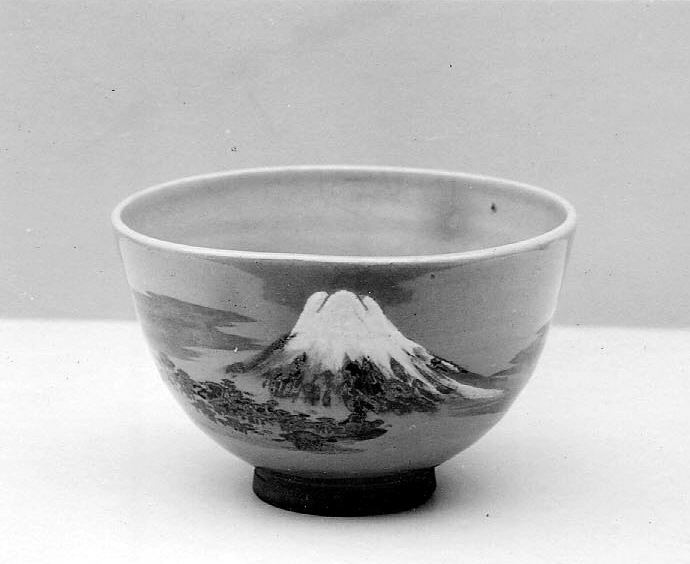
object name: bowl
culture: japanese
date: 1840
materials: ceramic glaze, enamel, faience, glaze, gold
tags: mountains